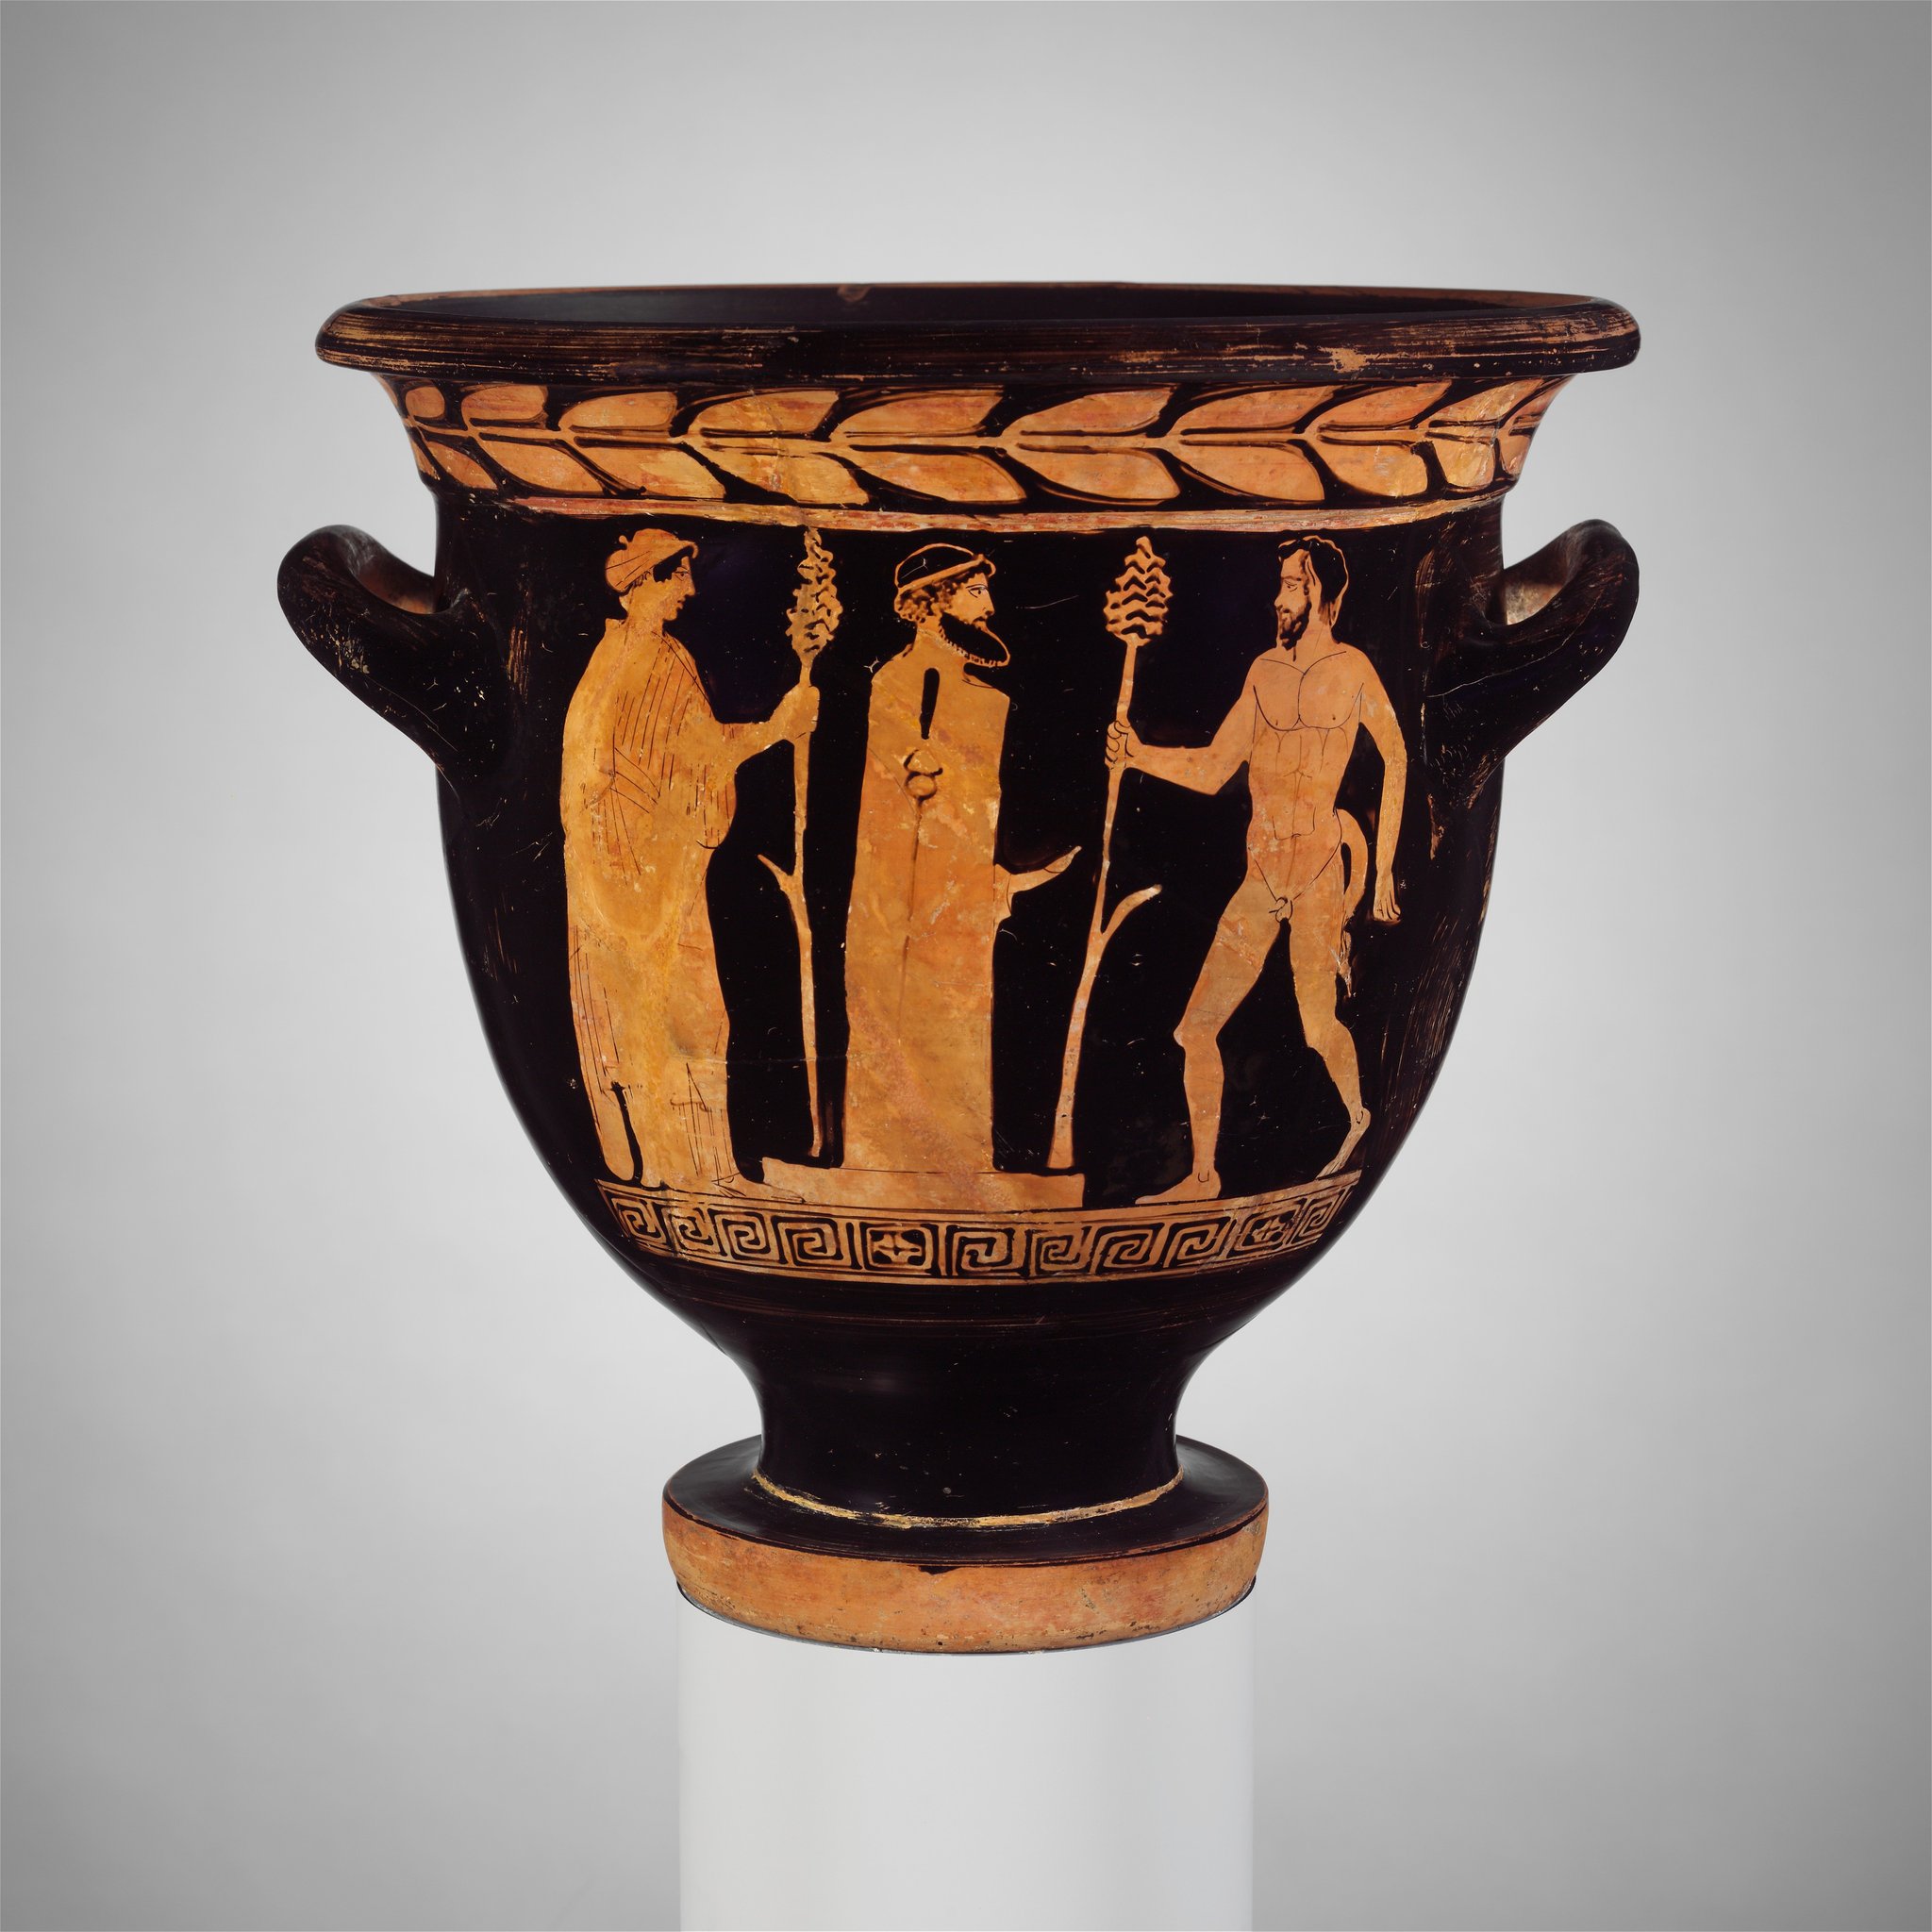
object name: bell krater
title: Terracotta bell-krater (mixing bowl)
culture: greek, south italian, lucanian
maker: pisticci painter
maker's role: artist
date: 430-410 BCE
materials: terracotta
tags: male nudes,women,maenads,satyrs